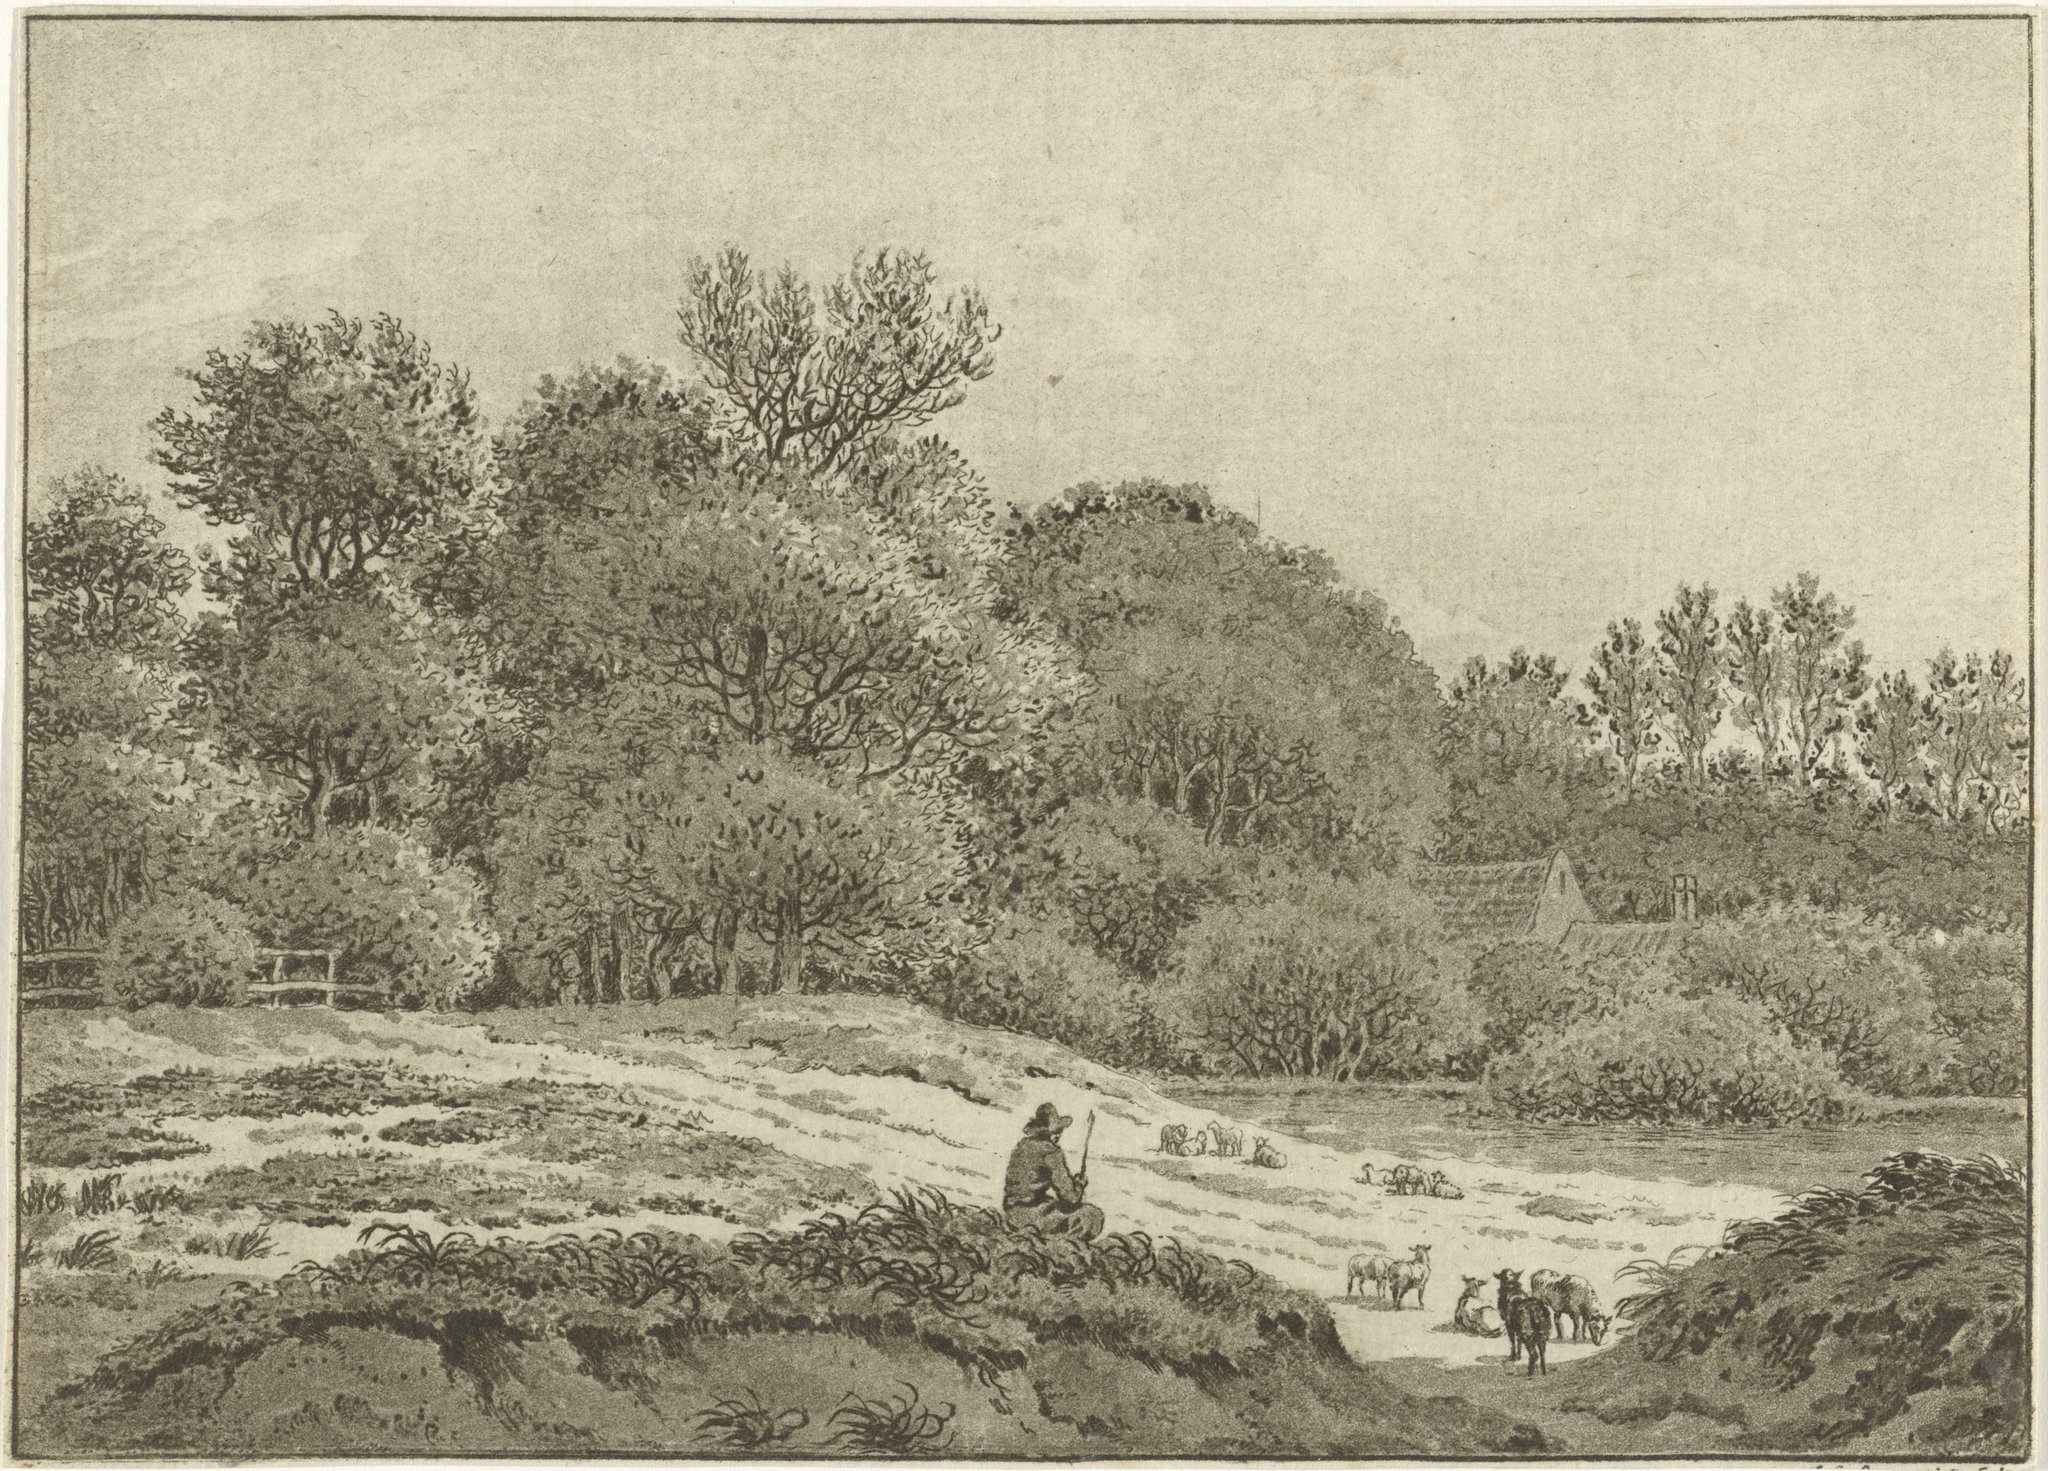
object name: print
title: Landschap bij Overveen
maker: jan evert grave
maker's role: draughtsman, print maker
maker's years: 1759-1805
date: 1769-1805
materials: paper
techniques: aquatint, etching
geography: amsterdam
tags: herding, herdsman, herdswoman, shepherd, shepherdess, cowherd, etc., forest, wood (+ landscape with figures, staffage)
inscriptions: collector's mark: Lugt 2233, inscription: ‘Te Overveen J.E. Grave T’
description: Een bebost landschap bij Overveen, met een herder op de voorgrond. Hij zit op een heuveltje naast zijn kudde. Op de achtergrond een huis.